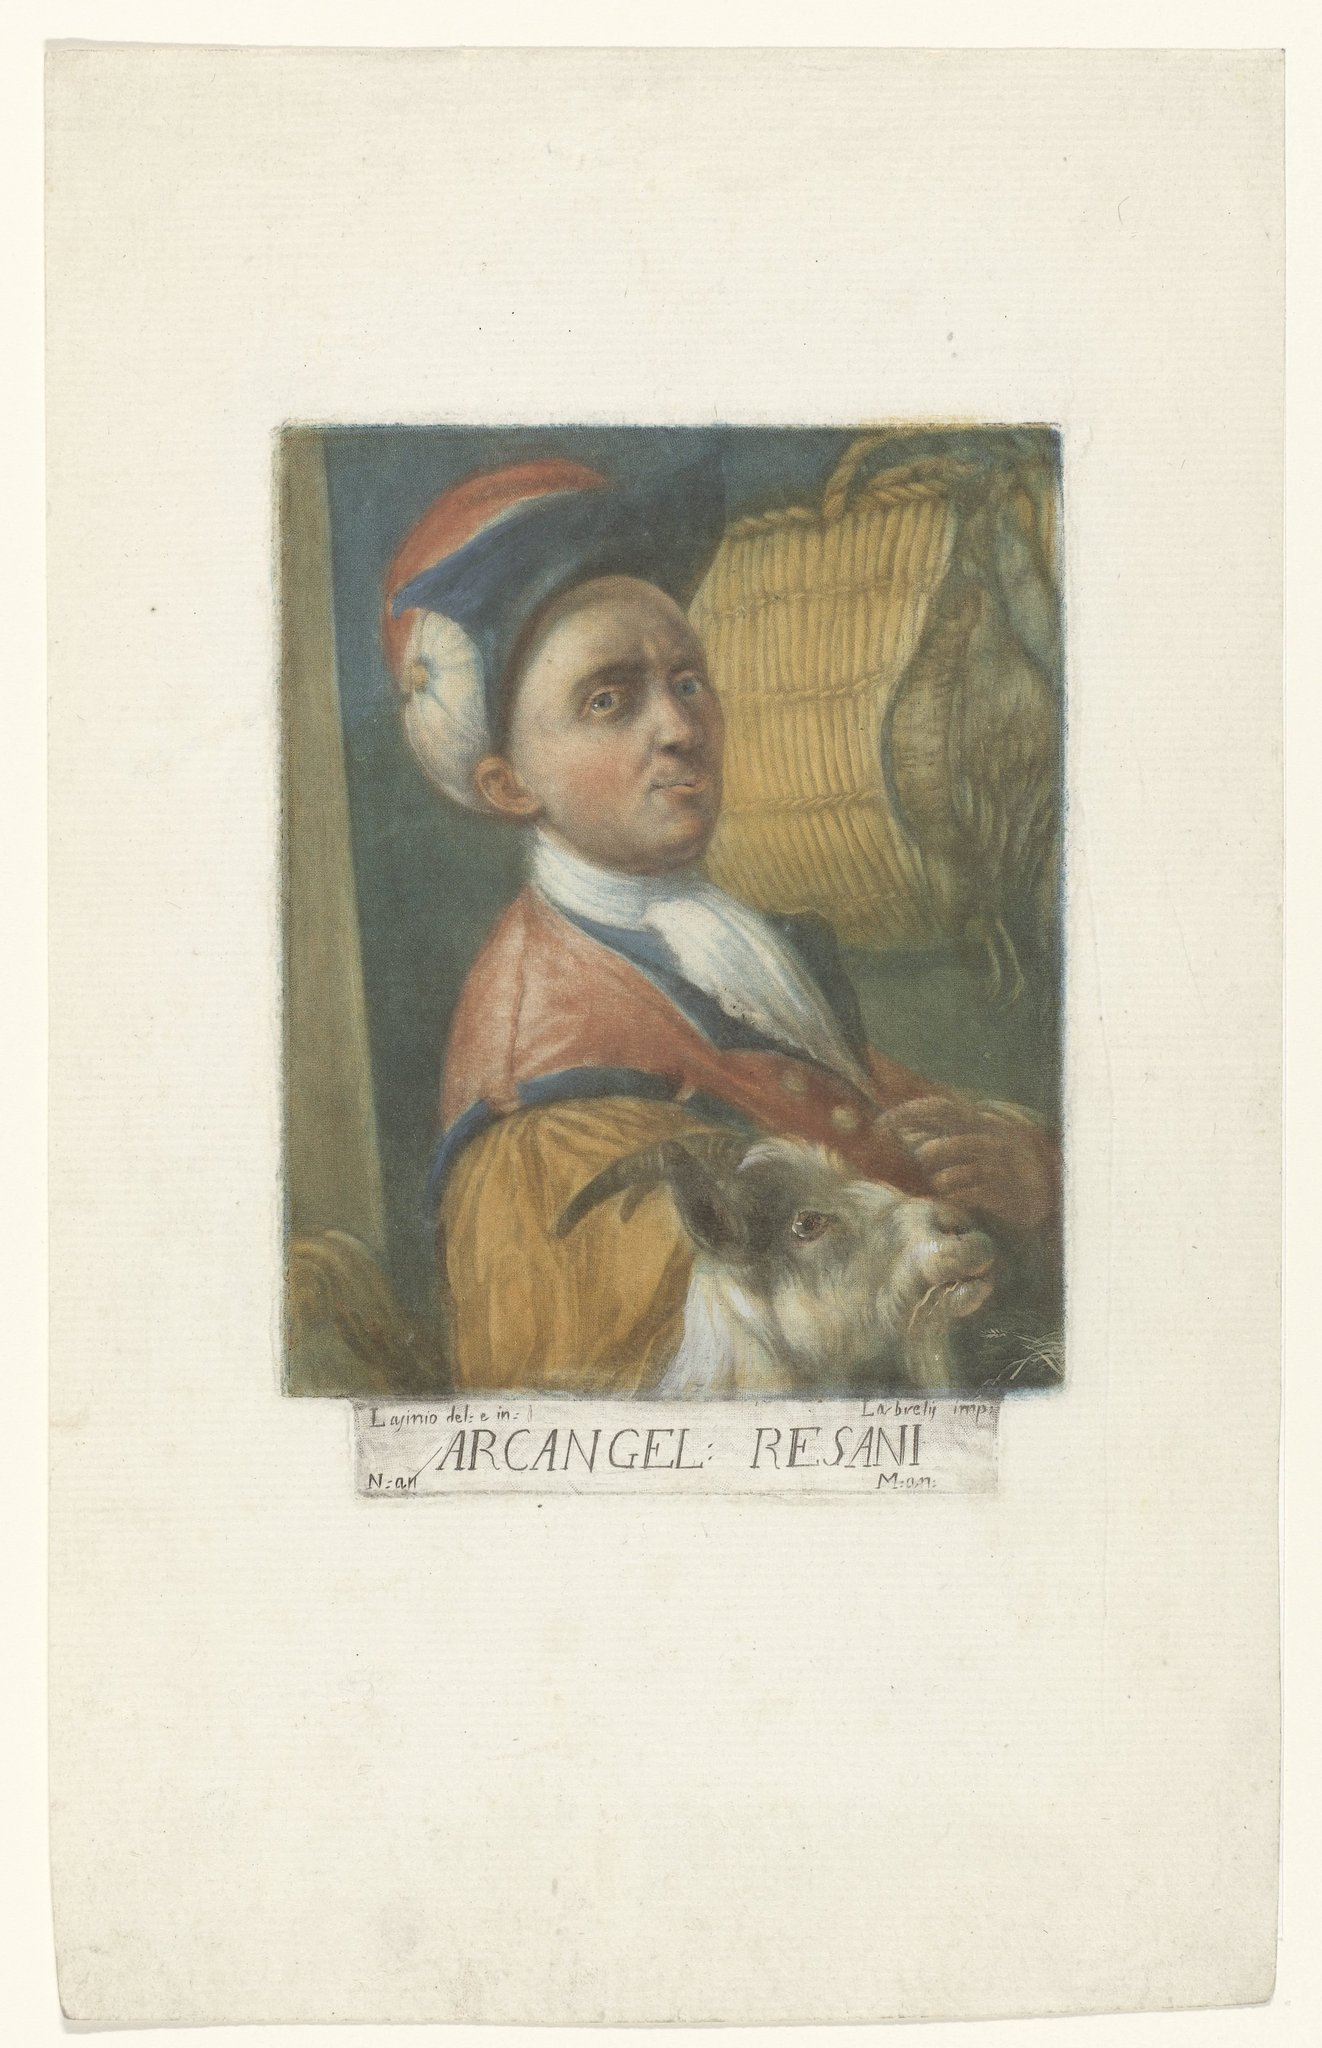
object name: print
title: Gli autoritratti della Real Galleria di Firenze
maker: carlo lasinio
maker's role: painter, print maker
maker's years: 1759-1838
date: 1789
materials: paper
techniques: color mezzotint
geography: italy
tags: painter, arcangelo resani, historical persons, portrait, self-portrait of artist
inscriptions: collector's mark: Lugt 2228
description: Naar een geschilderd zelfportret door Resani in de Galleria degli Uffizi te Florence. Prent uit: Carlo Lasiano, Gli Autoritratti della Real Galleria di Firenze, 1789.